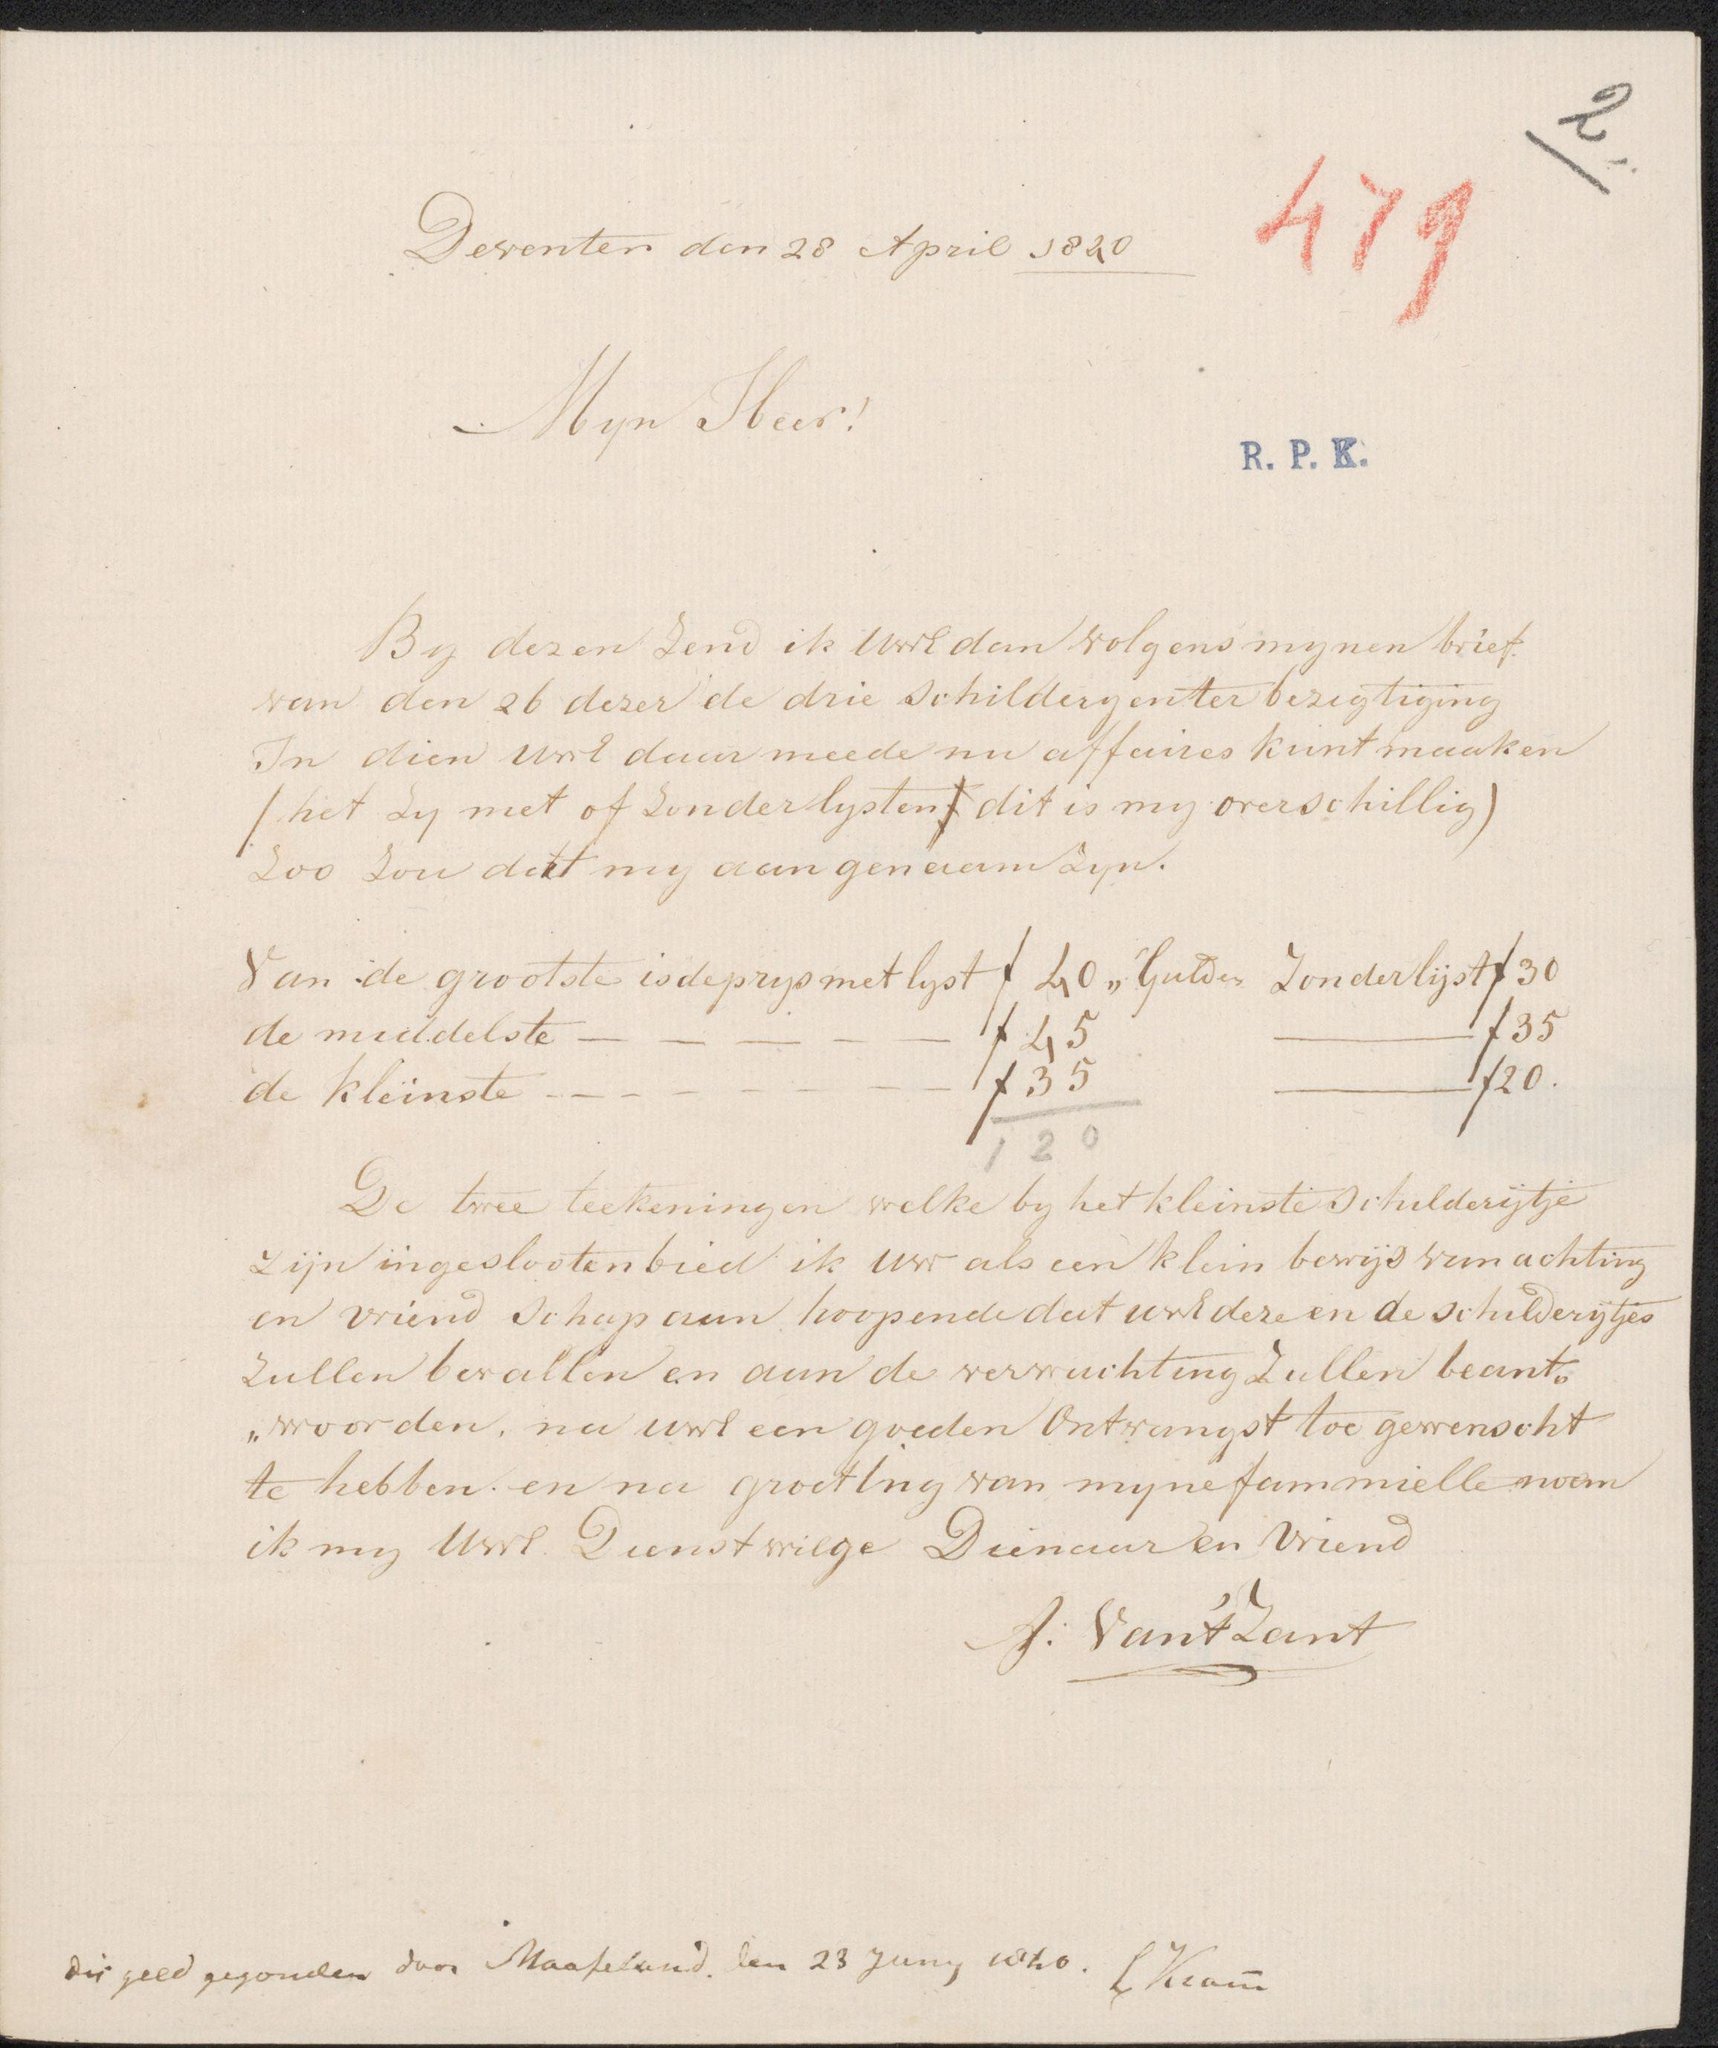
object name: letter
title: Brief aan Christiaan Kramm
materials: ink, paper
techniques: pen, writing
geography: deventer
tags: utrecht, print maker, draughtsman, christiaan kramm, drawing, painting (including book-illumination, miniature-painting), money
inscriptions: watermark, collector's mark: Lugt 2233